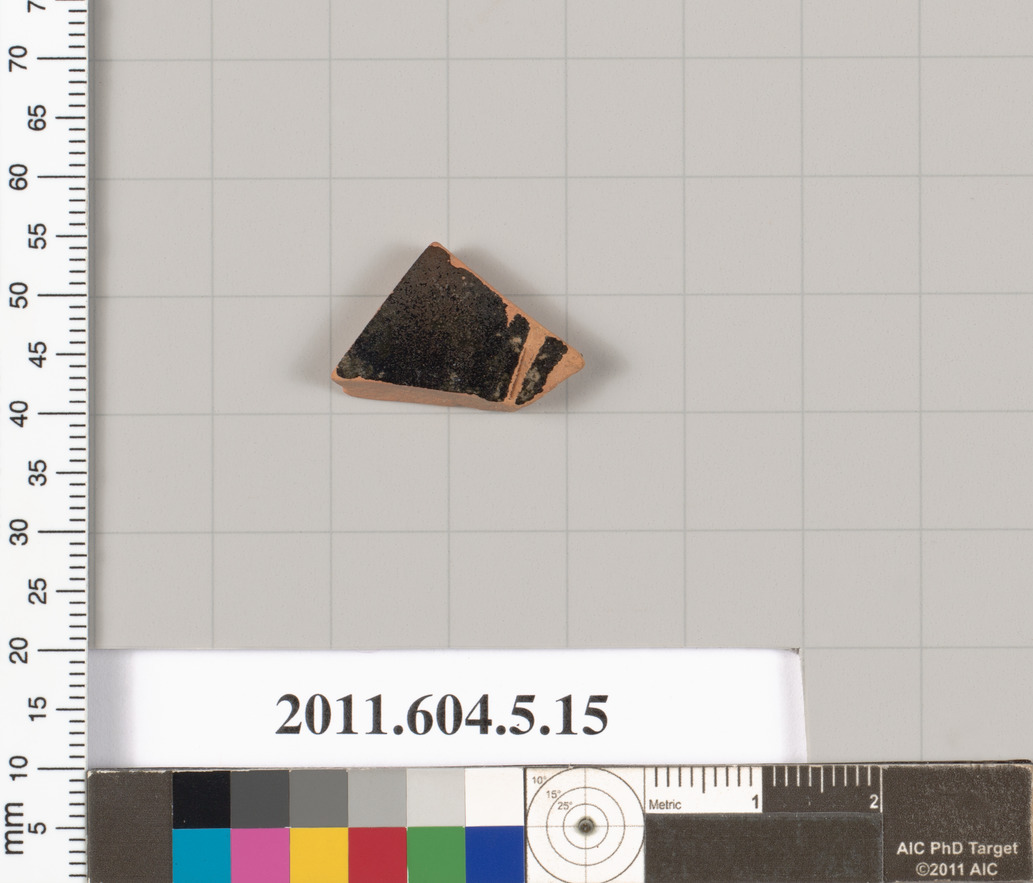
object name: kylix fragment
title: Terracotta fragment of a kylix (drinking cup)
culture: greek, attic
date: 475-451 BCE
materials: terracotta